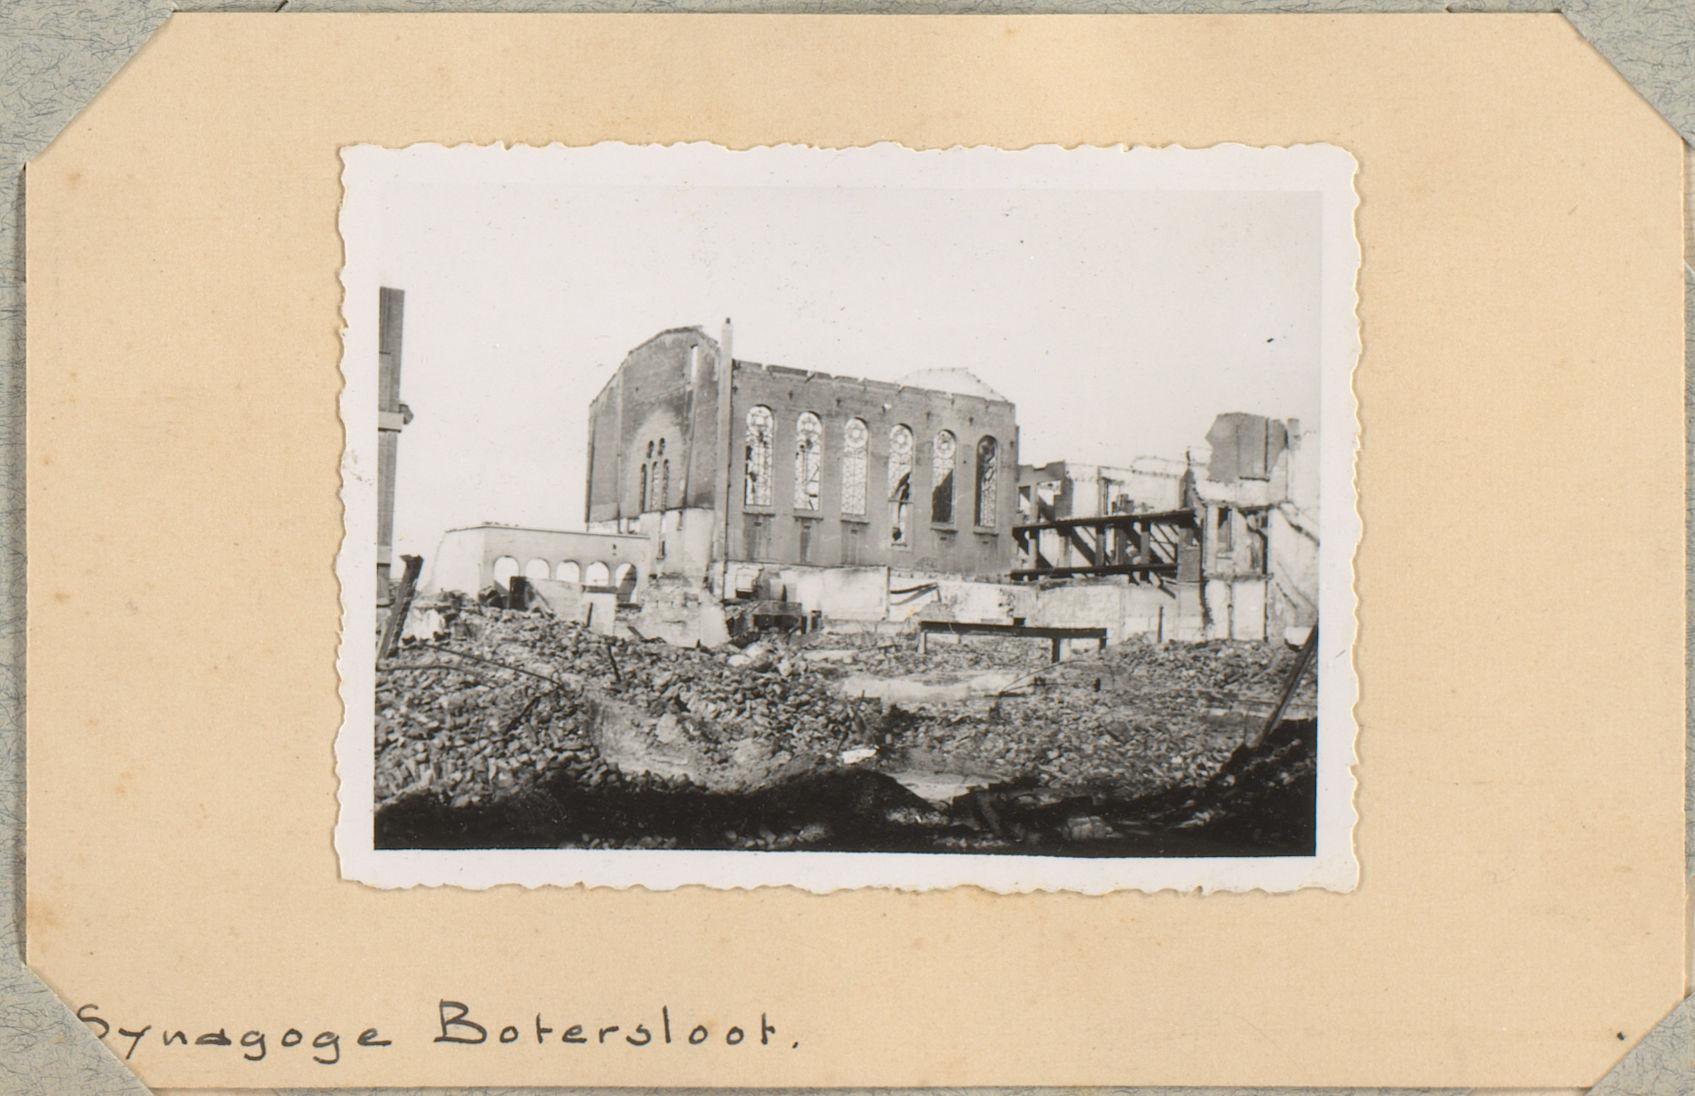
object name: photograph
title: Ruïne van een synagoge aan de Botersloot te Rotterdam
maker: j. nolte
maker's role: fotograaf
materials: photographic support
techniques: gelatin silver print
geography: rotterdam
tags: the synagogue (as building and place of worship ~ jewish religion), devastated, ruined place or city (~ warfare), ruin of a dwelling, house, castle, etc., rotterdam, rotterdam blitz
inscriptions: annotation: ‘Synagoge Boterloot’